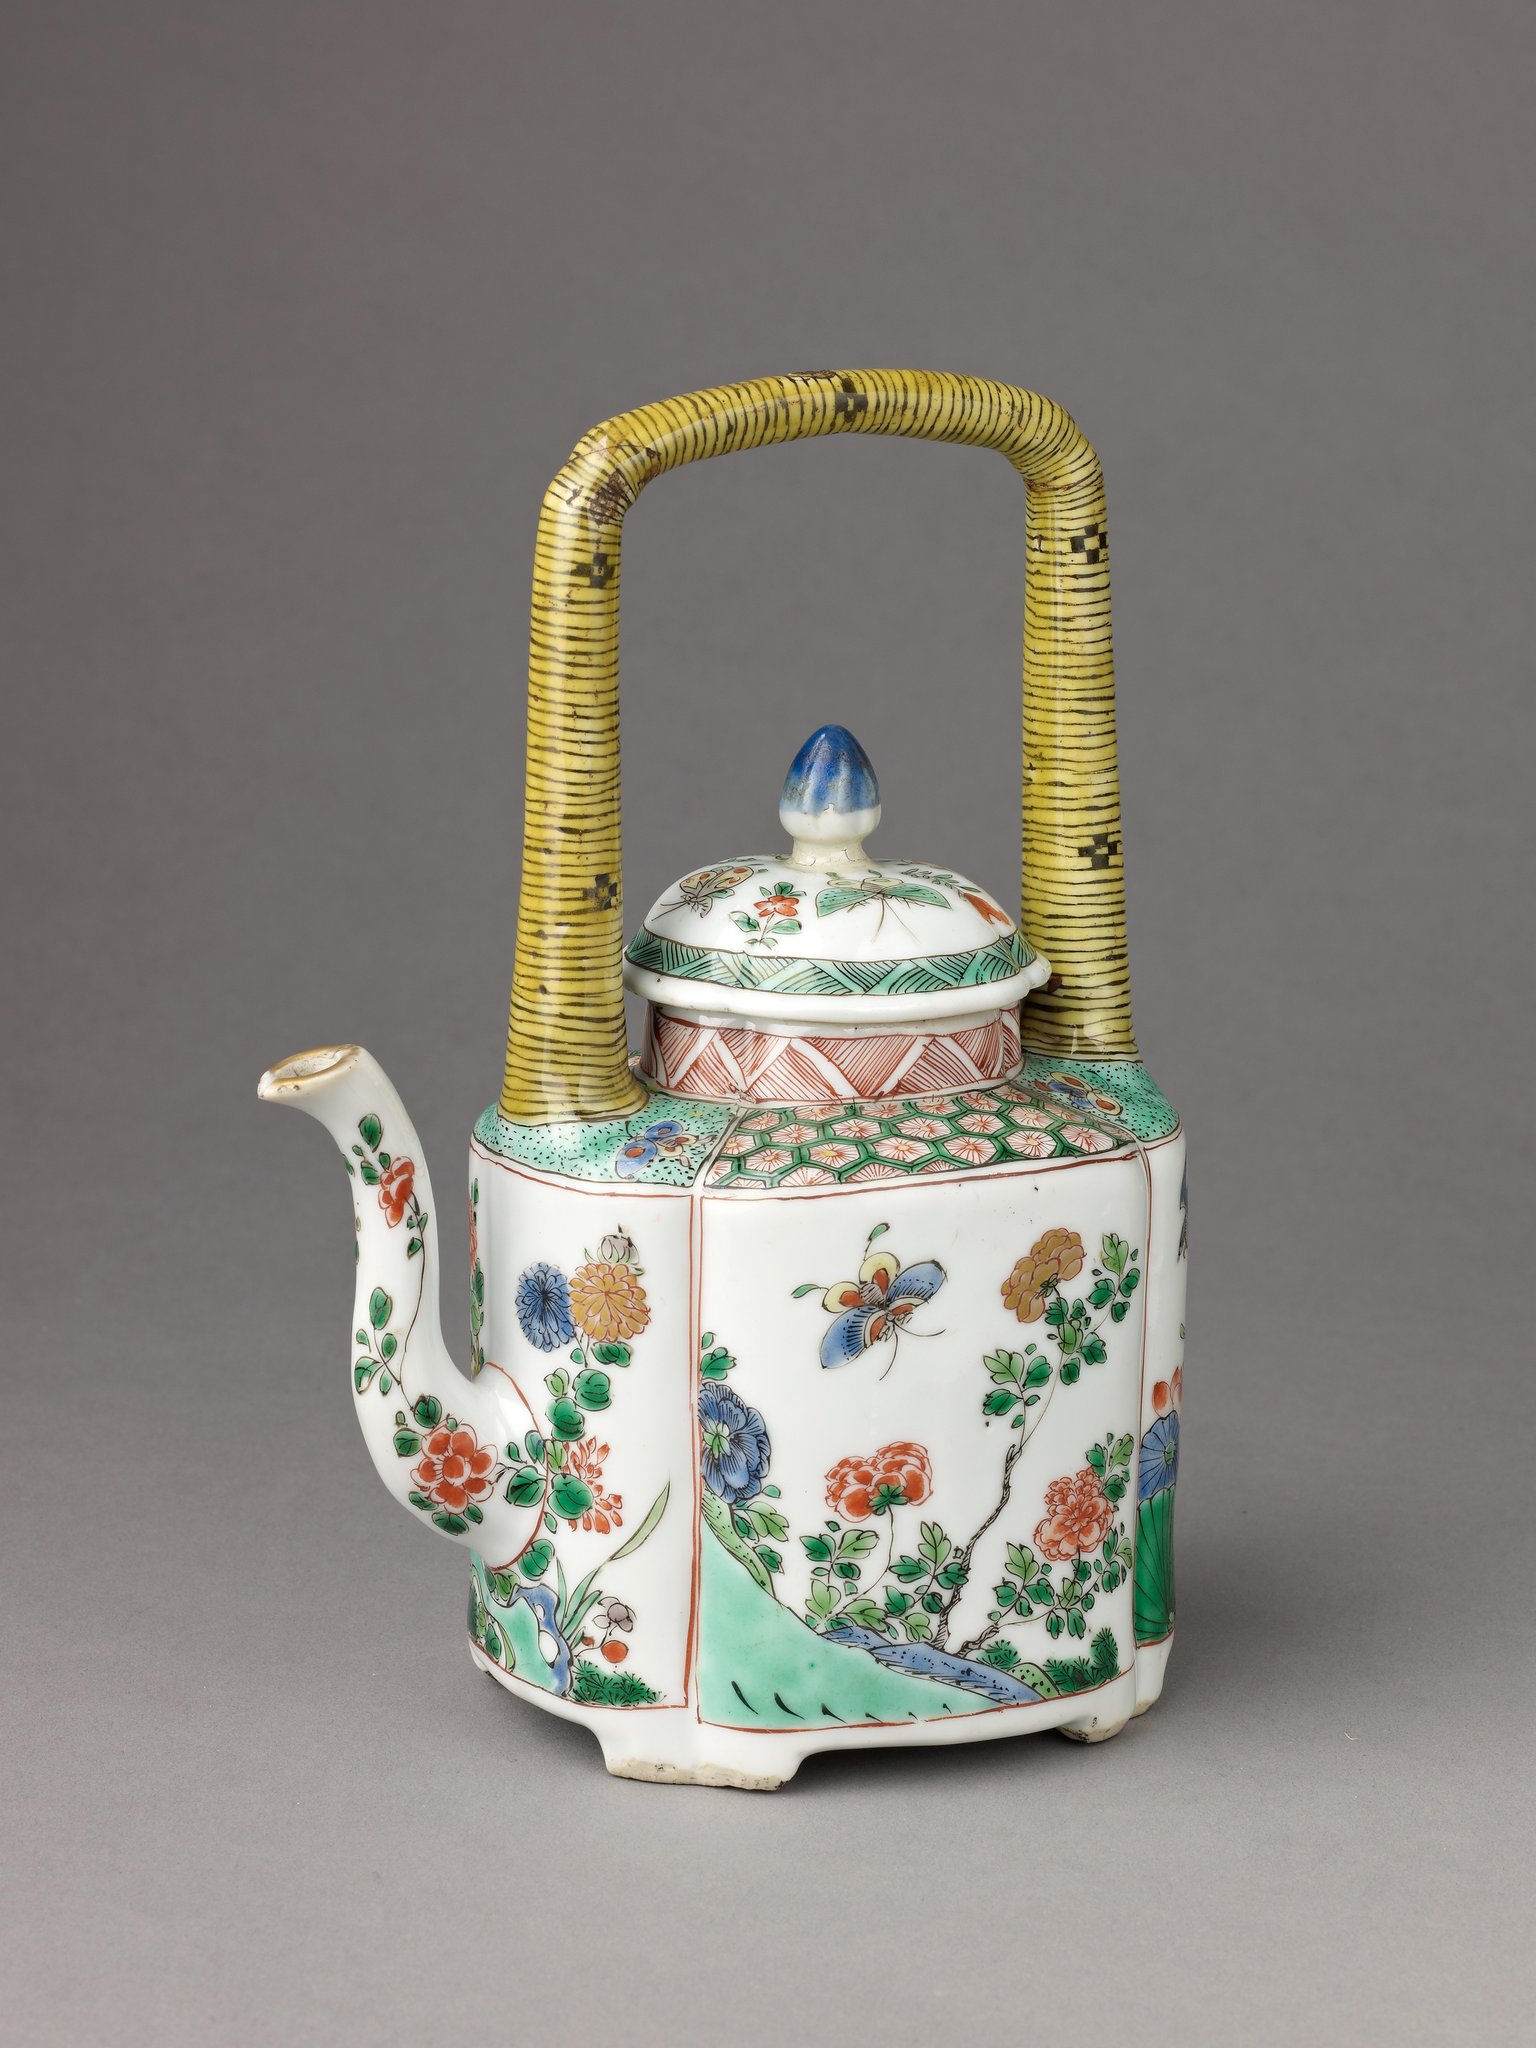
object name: covered winepot or teapot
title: Small covered wine pot or teapot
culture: chinese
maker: chinese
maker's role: artist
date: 1662-1722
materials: enamel, gilt, porcelain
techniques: overglaze, painting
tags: butterflies,flowers